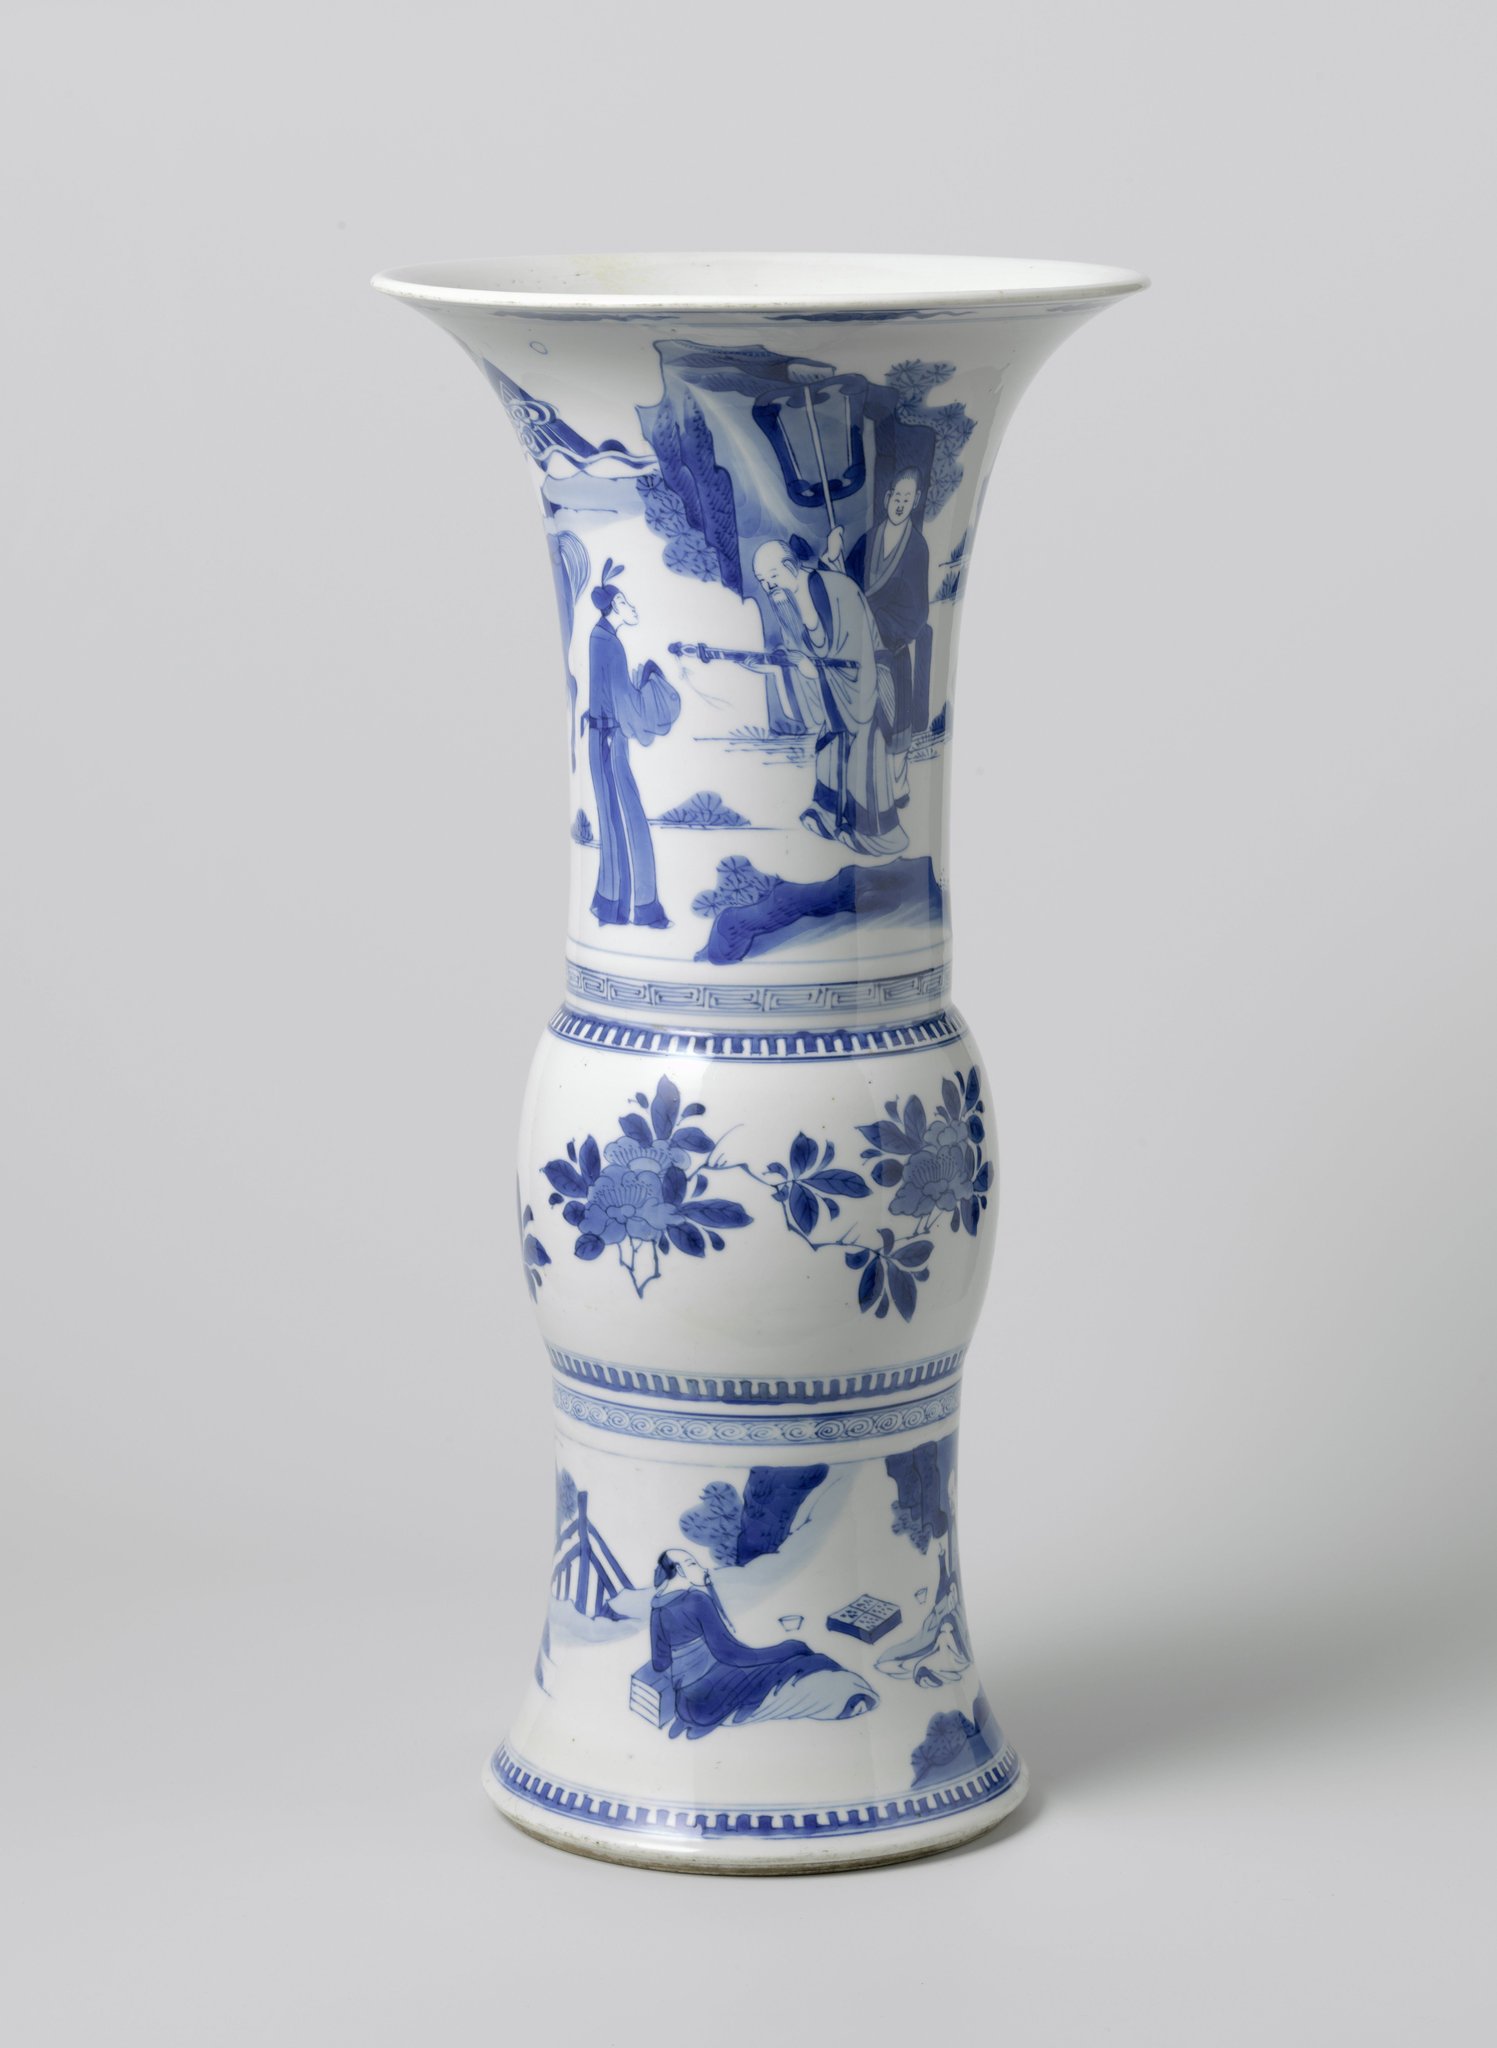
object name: vase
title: Gu-shaped vase with figures in a landscape and flower sprays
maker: Anonymous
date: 1680-1720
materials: cobalt, glaze, paint, porcelain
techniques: firing, turning, vitrification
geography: china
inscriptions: mark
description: Vaas, bekervormig in onderglazuurblauw met voorstelling van twee wijsgeren op de voet en azaleatakken op de nodus. Gemerkt.